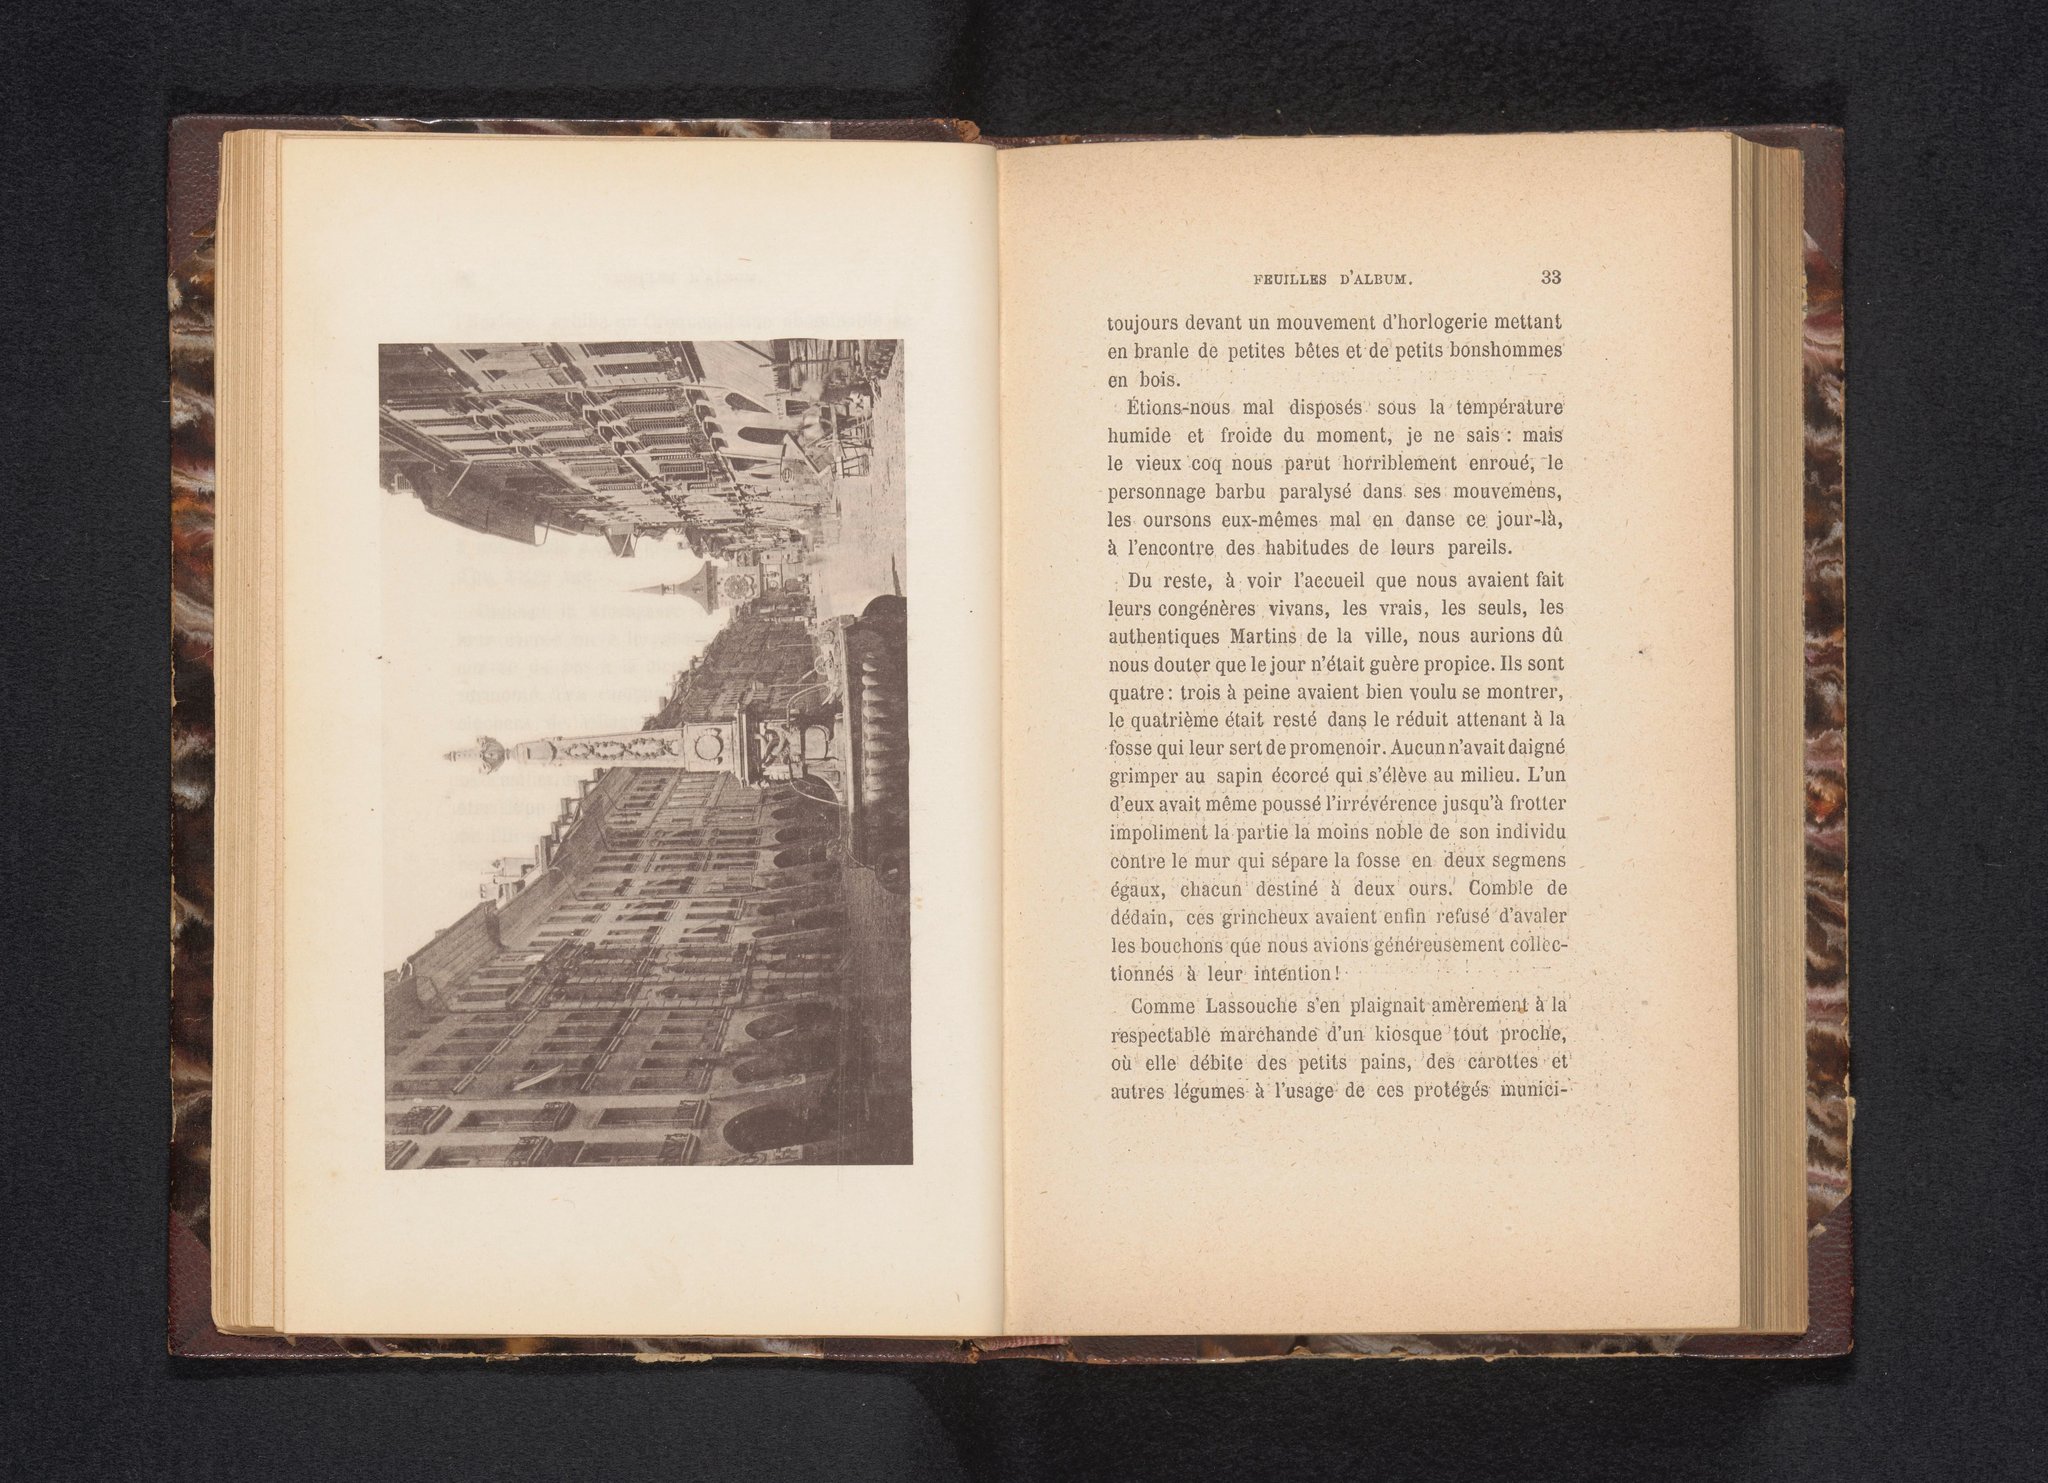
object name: page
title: Straatgezicht van de Kramgasse te Bern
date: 1884-1889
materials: paper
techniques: photograph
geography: bern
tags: city-view in general; 'veduta', street